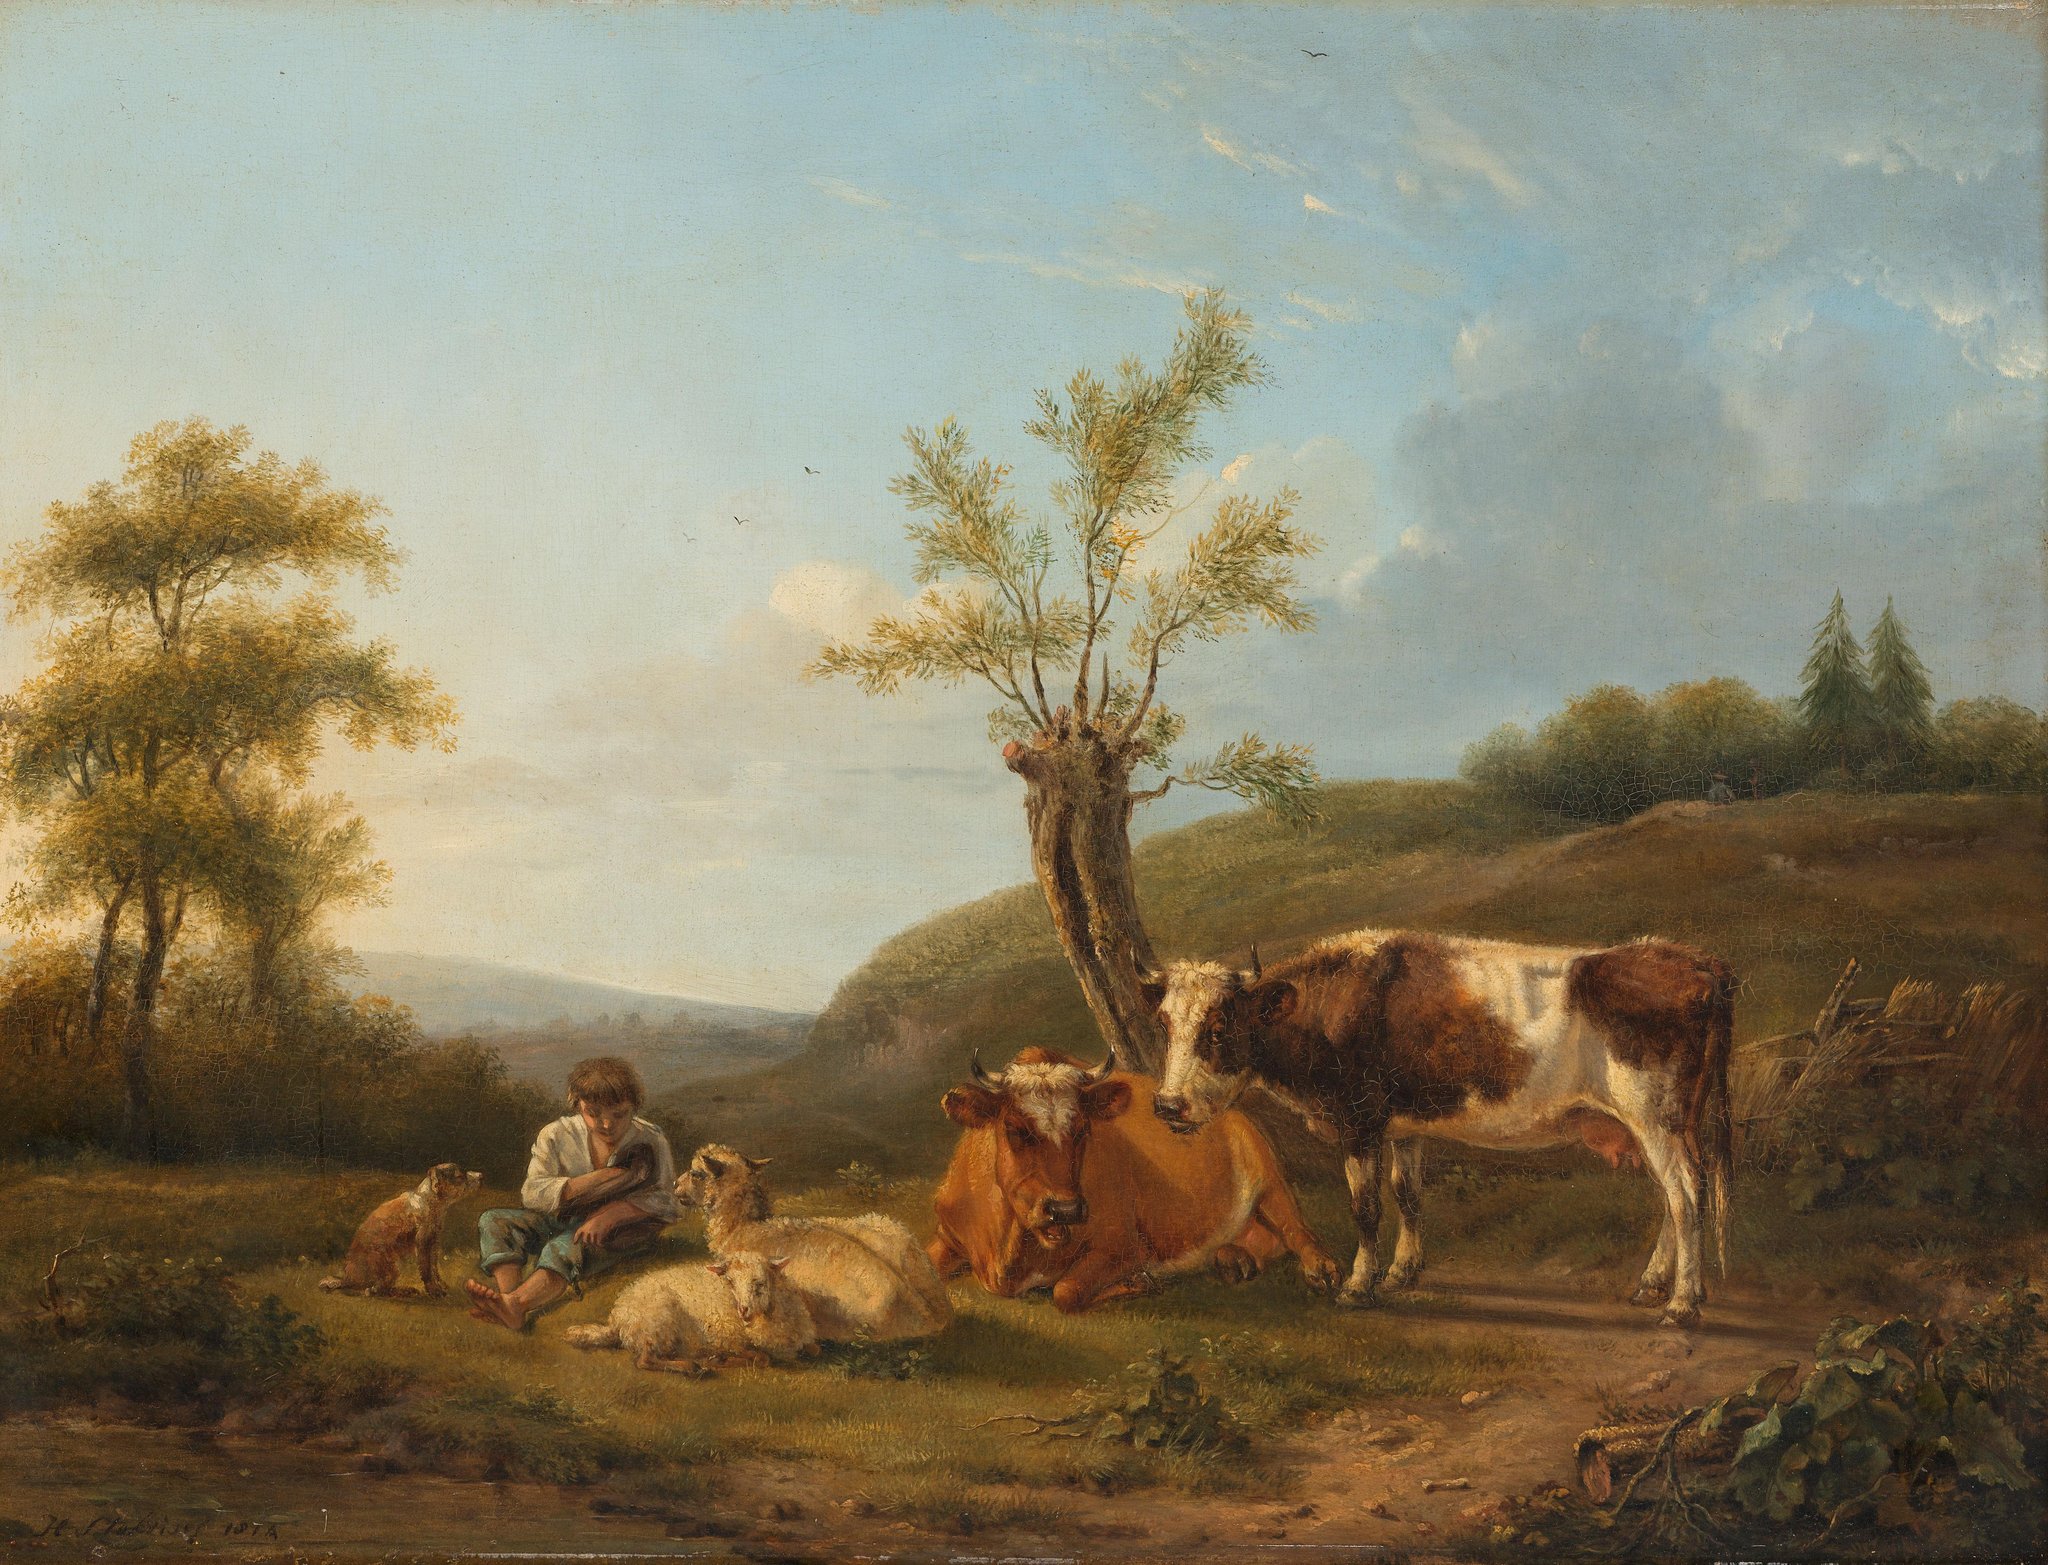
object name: painting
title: Landscape with Cattle near Darthuizen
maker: hendrik stokvisch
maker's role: draughtsman, painter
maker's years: 1768-1820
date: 1814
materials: oil, panel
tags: low hill country, cow, herding, herdsman, herdswoman, shepherd, shepherdess, cowherd, etc.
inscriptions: signature and date: ‘H. Stockvisch 1814’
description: Landschap met vee bij Darthuizen. Een herdersjongen zittend in het gras bij een hond, twee schapen en twee koeien.